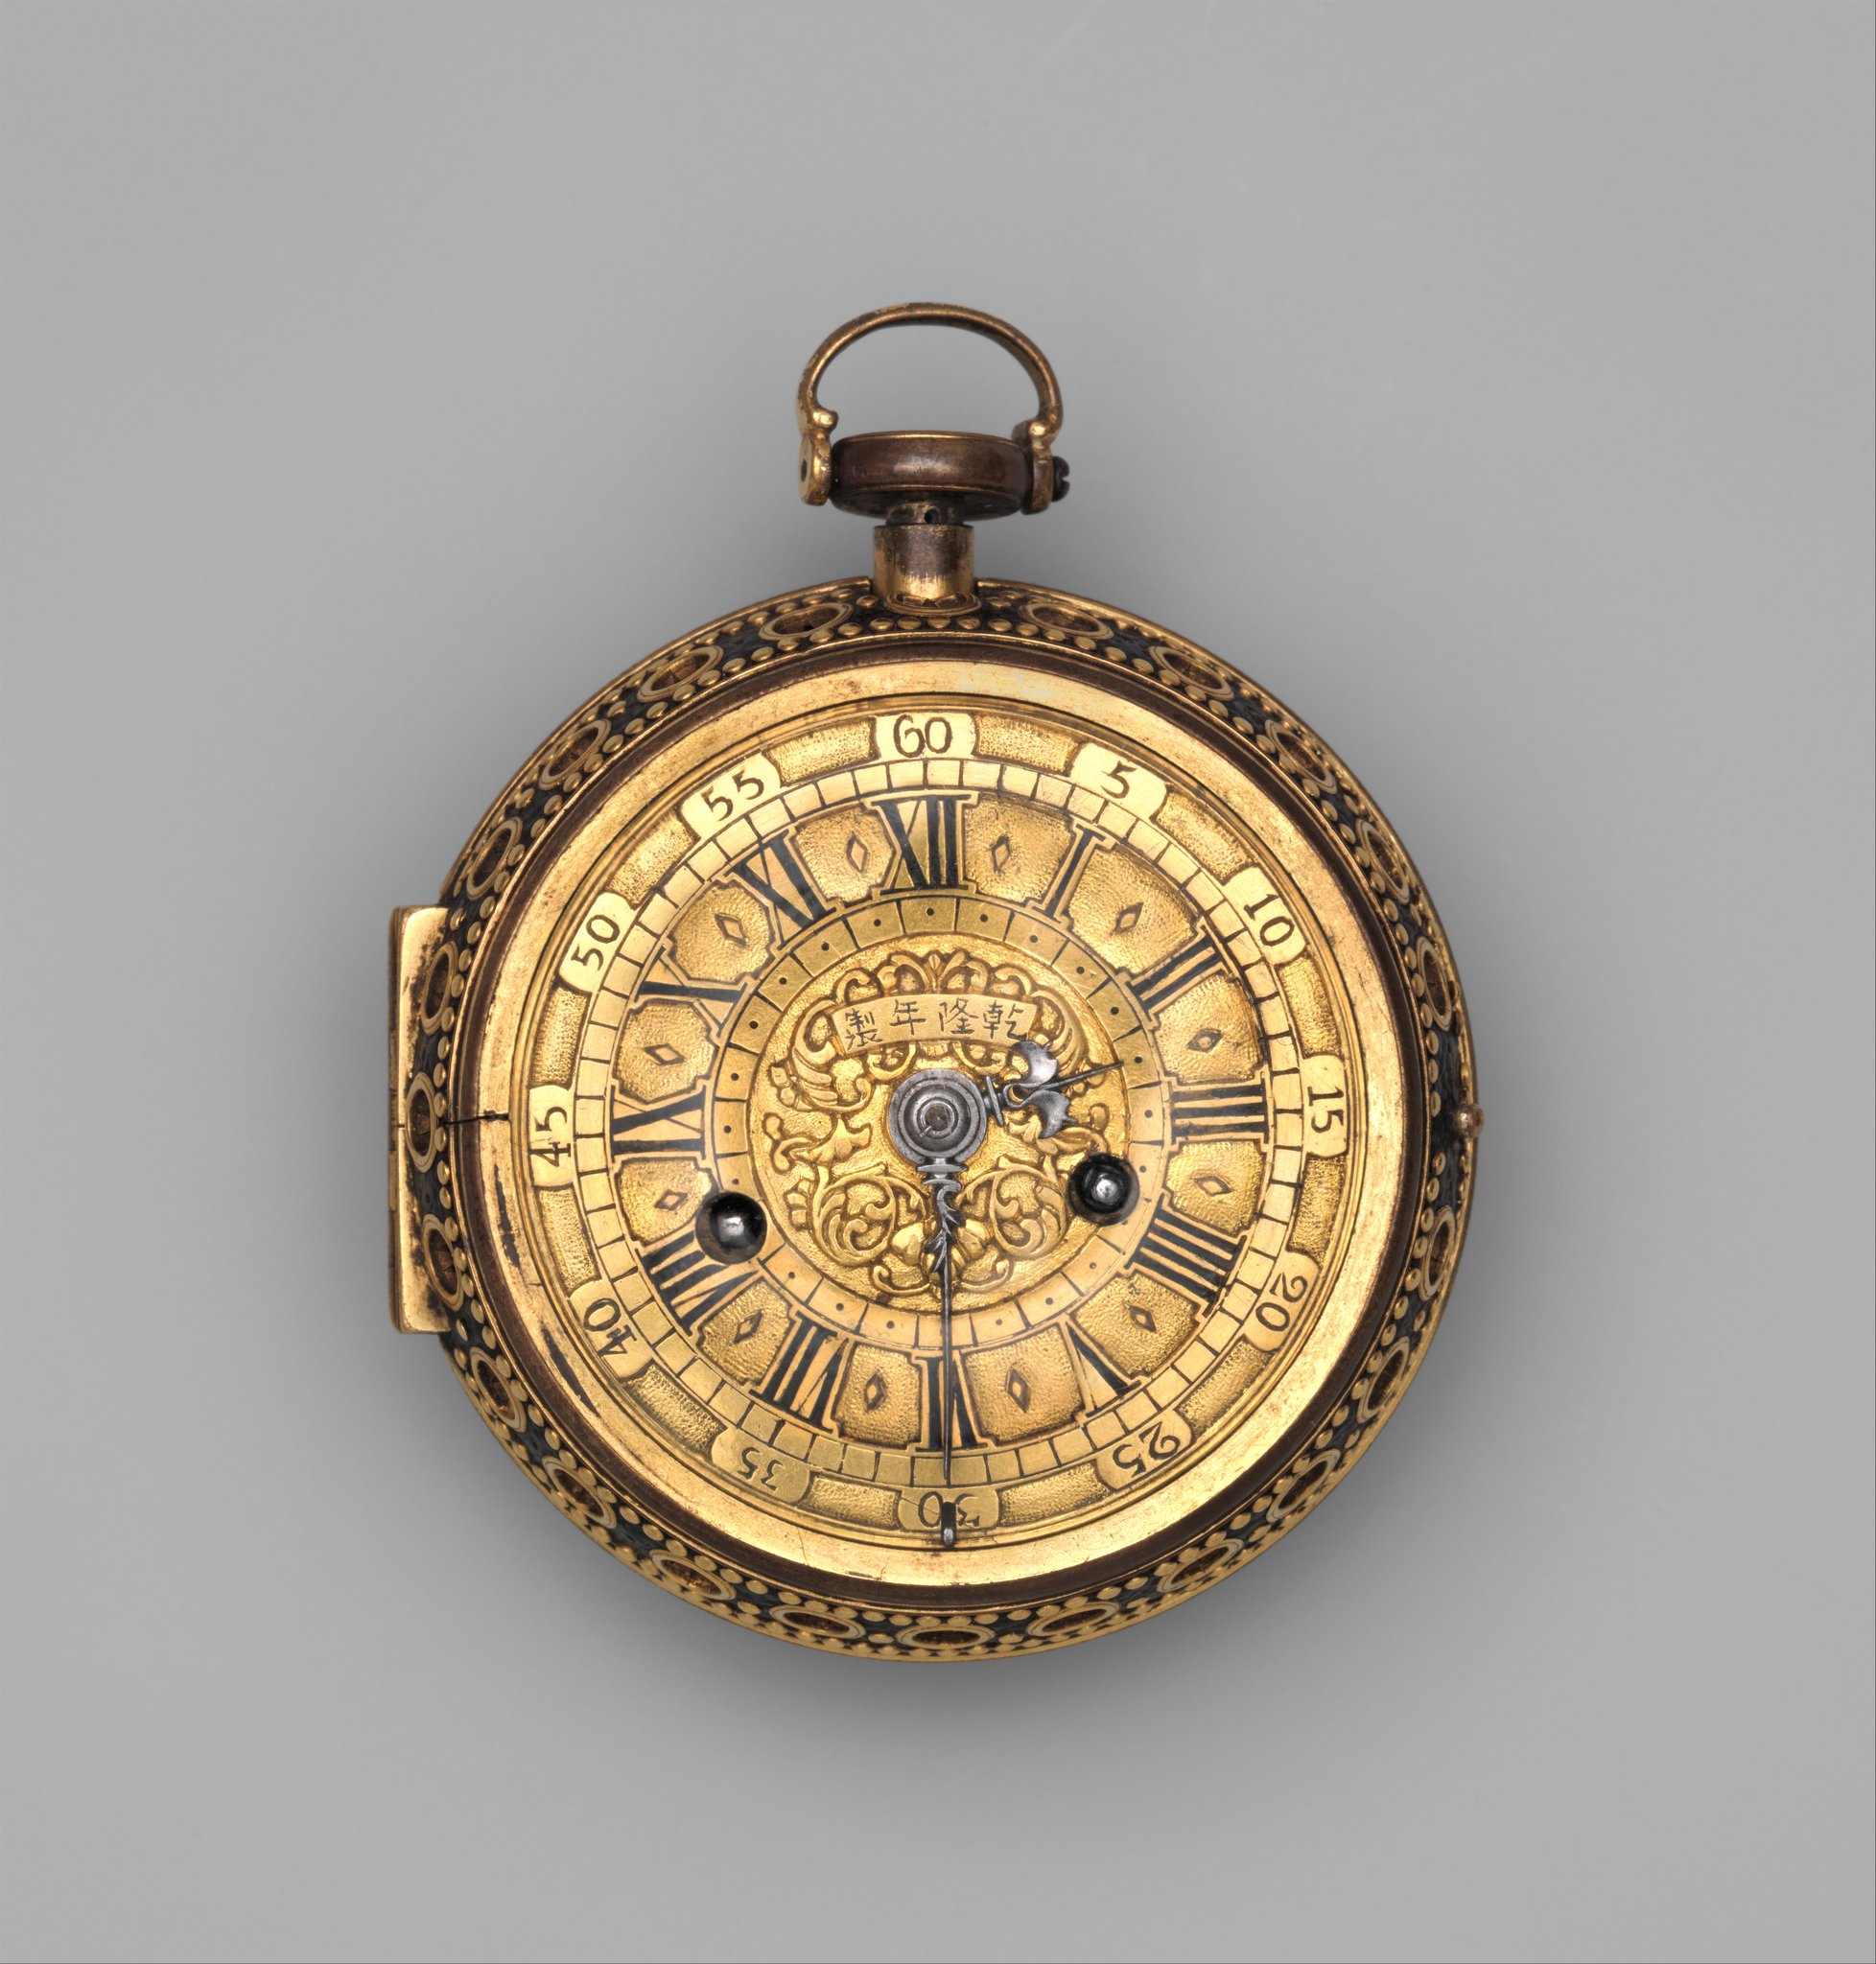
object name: clock watch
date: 1736-1795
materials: gilt brass, gold, leather, skin, steel